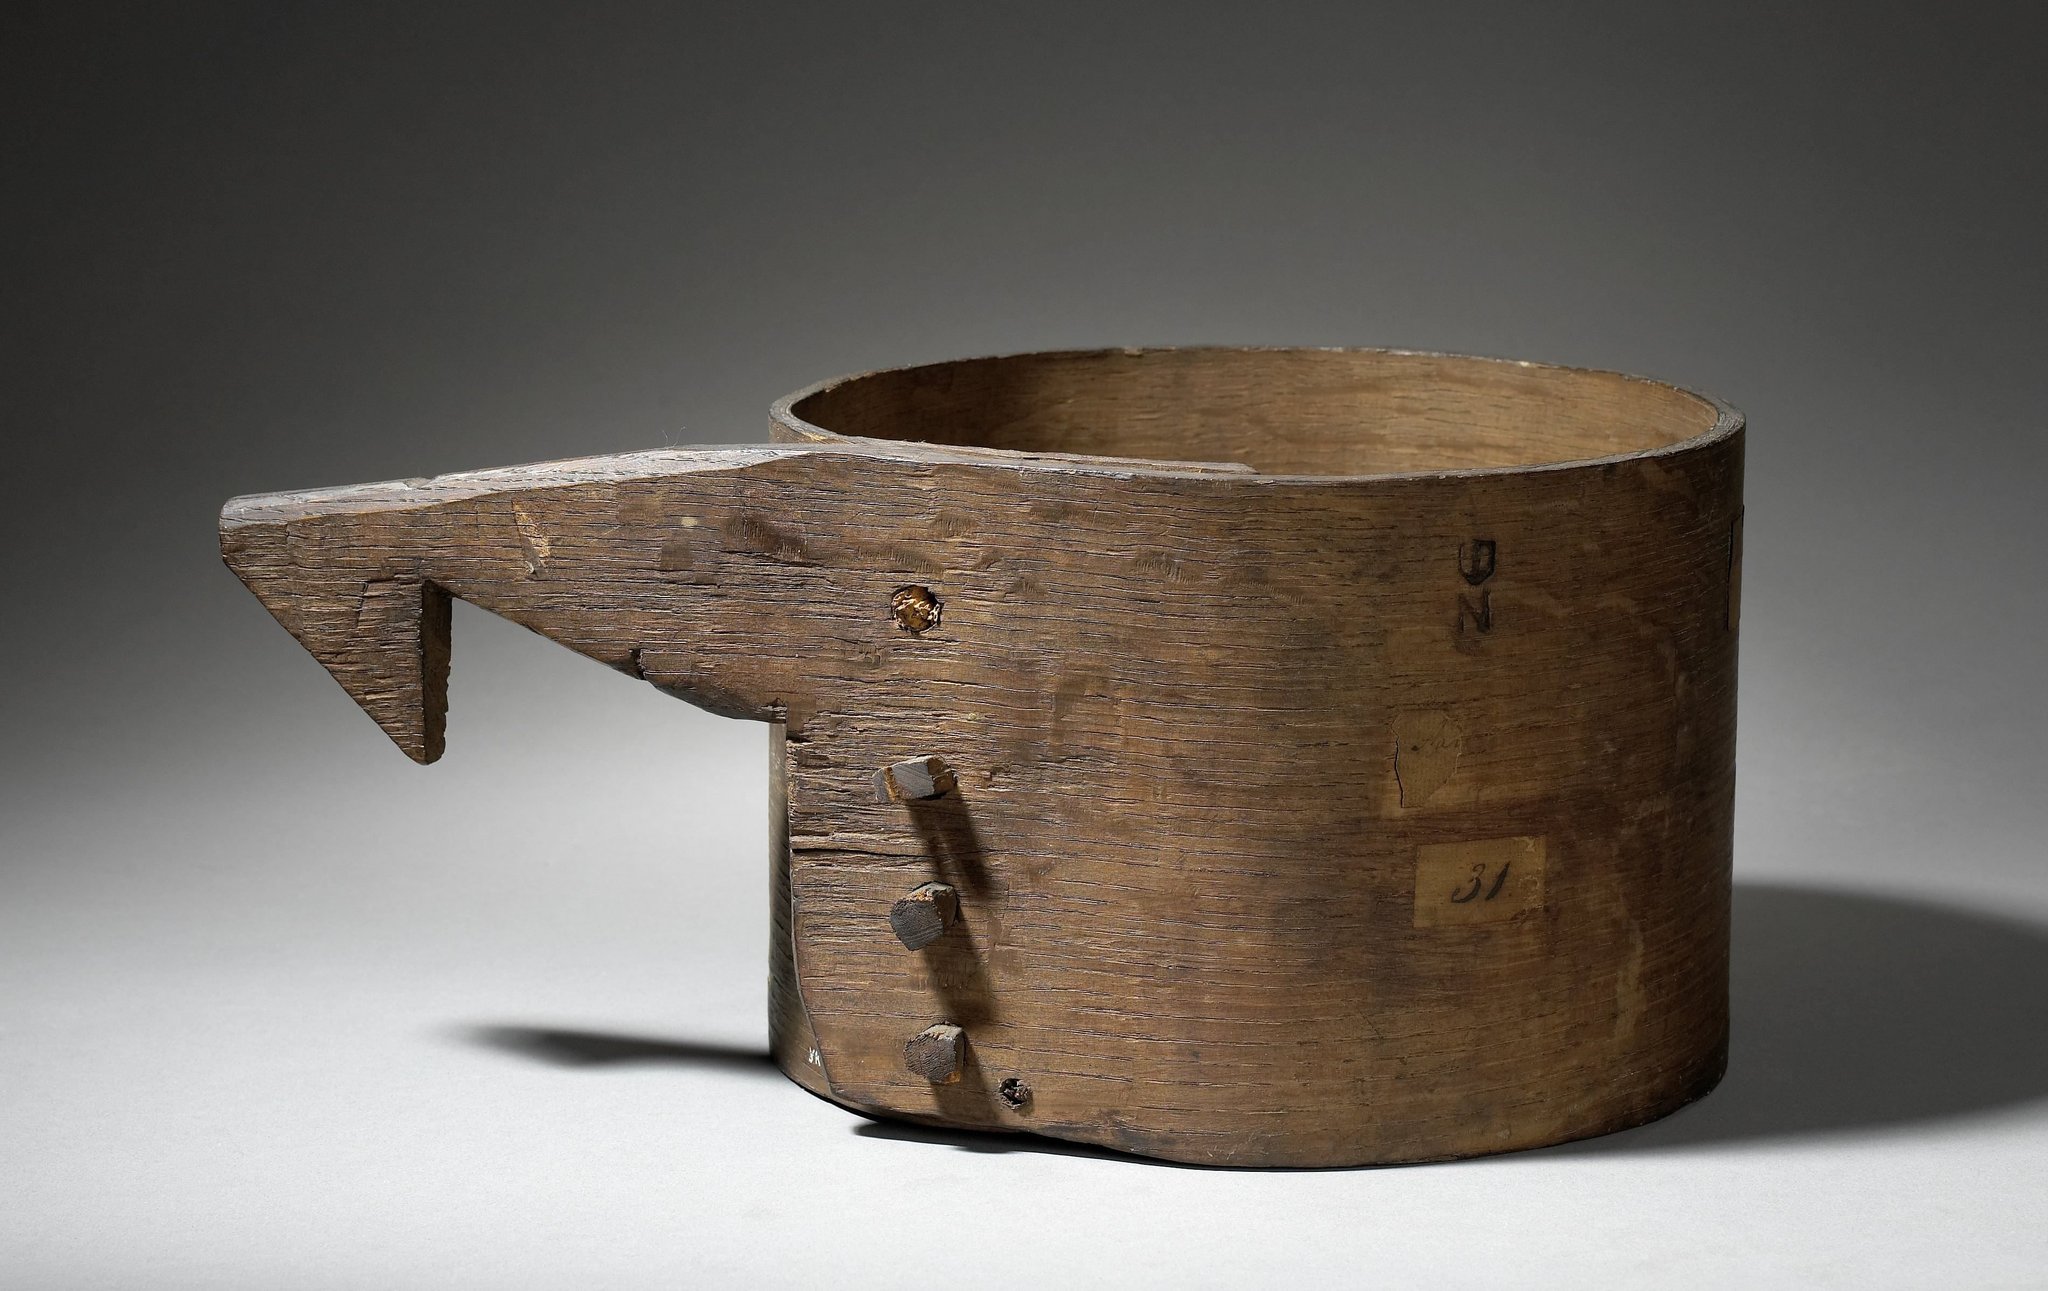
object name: aardappelmaat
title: 1/32 Boisseau uit Delft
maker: Anonymous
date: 1800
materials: wood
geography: delft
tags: delft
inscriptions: inscription: ‘Delft / Een Aardappelmaat’, title: ‘Aar’, title: ‘Delft 1/32 Boisseau / Pommes de’, number: ‘31’, inscription: ‘AARDAPPELMAAT (Delft)’, : ‘N’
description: Spanen aardappelmaat van 1/32 Boisseau met handgreep. Gemerkt en v.z.v. etiketten.